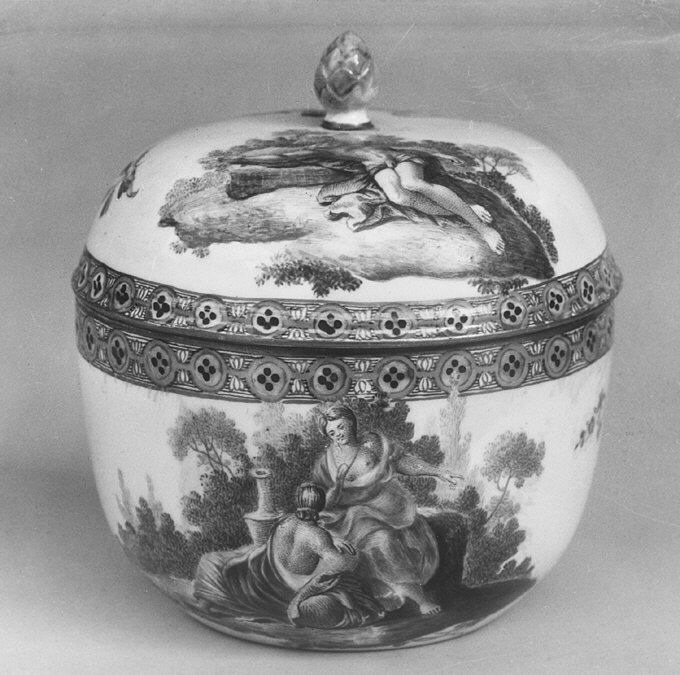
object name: sugar bowl with cover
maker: frankenthal porcelain manufactory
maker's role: manufactory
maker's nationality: german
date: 1765-1770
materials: hard paste porcelain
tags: women